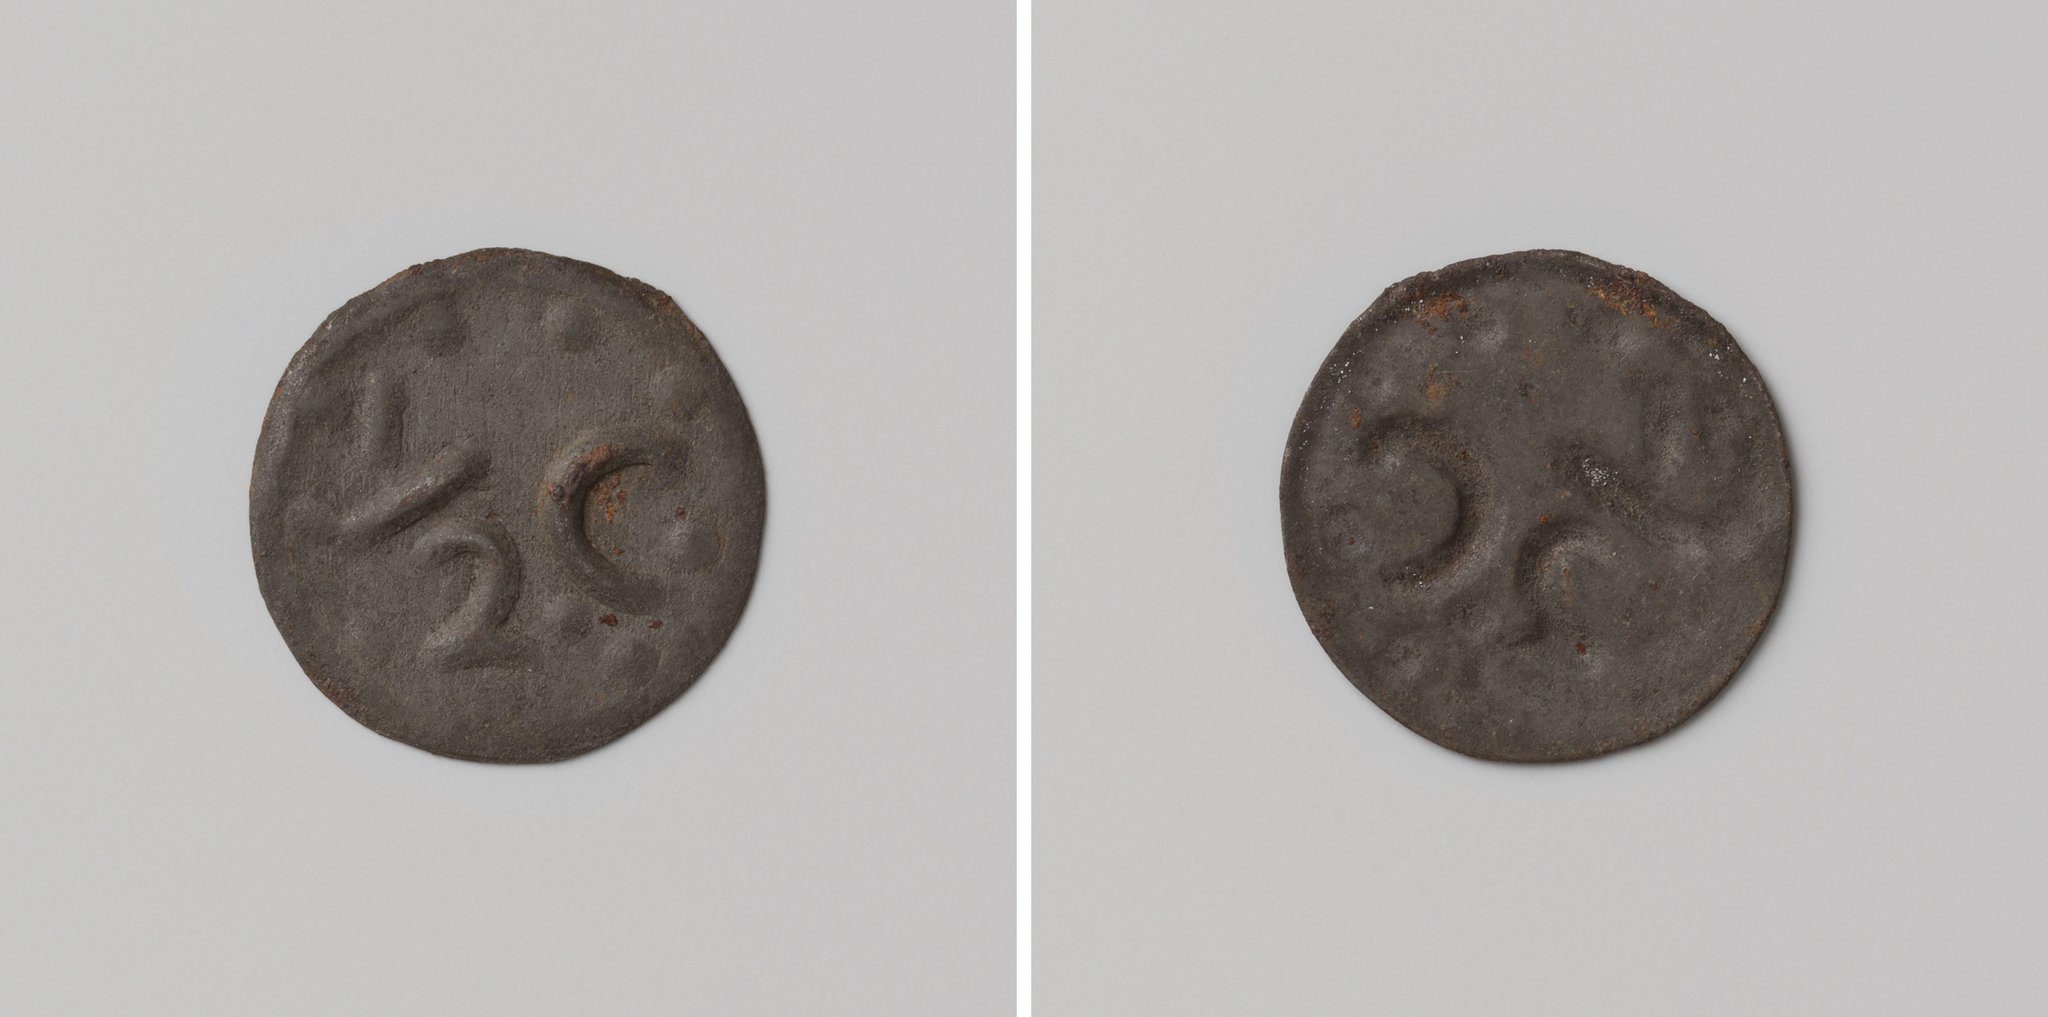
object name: monetary token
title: Strafgevangenis Ommerschans, huismunt geslagen op last van de Maatschappij van Weldadigheid ter waarde van ½ cent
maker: Anonymous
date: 1822-1830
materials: metal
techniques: striking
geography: ommerschans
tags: maatschappij van weldadigheid, ommerschans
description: eenzijdige munt. Voorzijde: waardeaanduiding binnen parelrand. Keerzijde: blanco